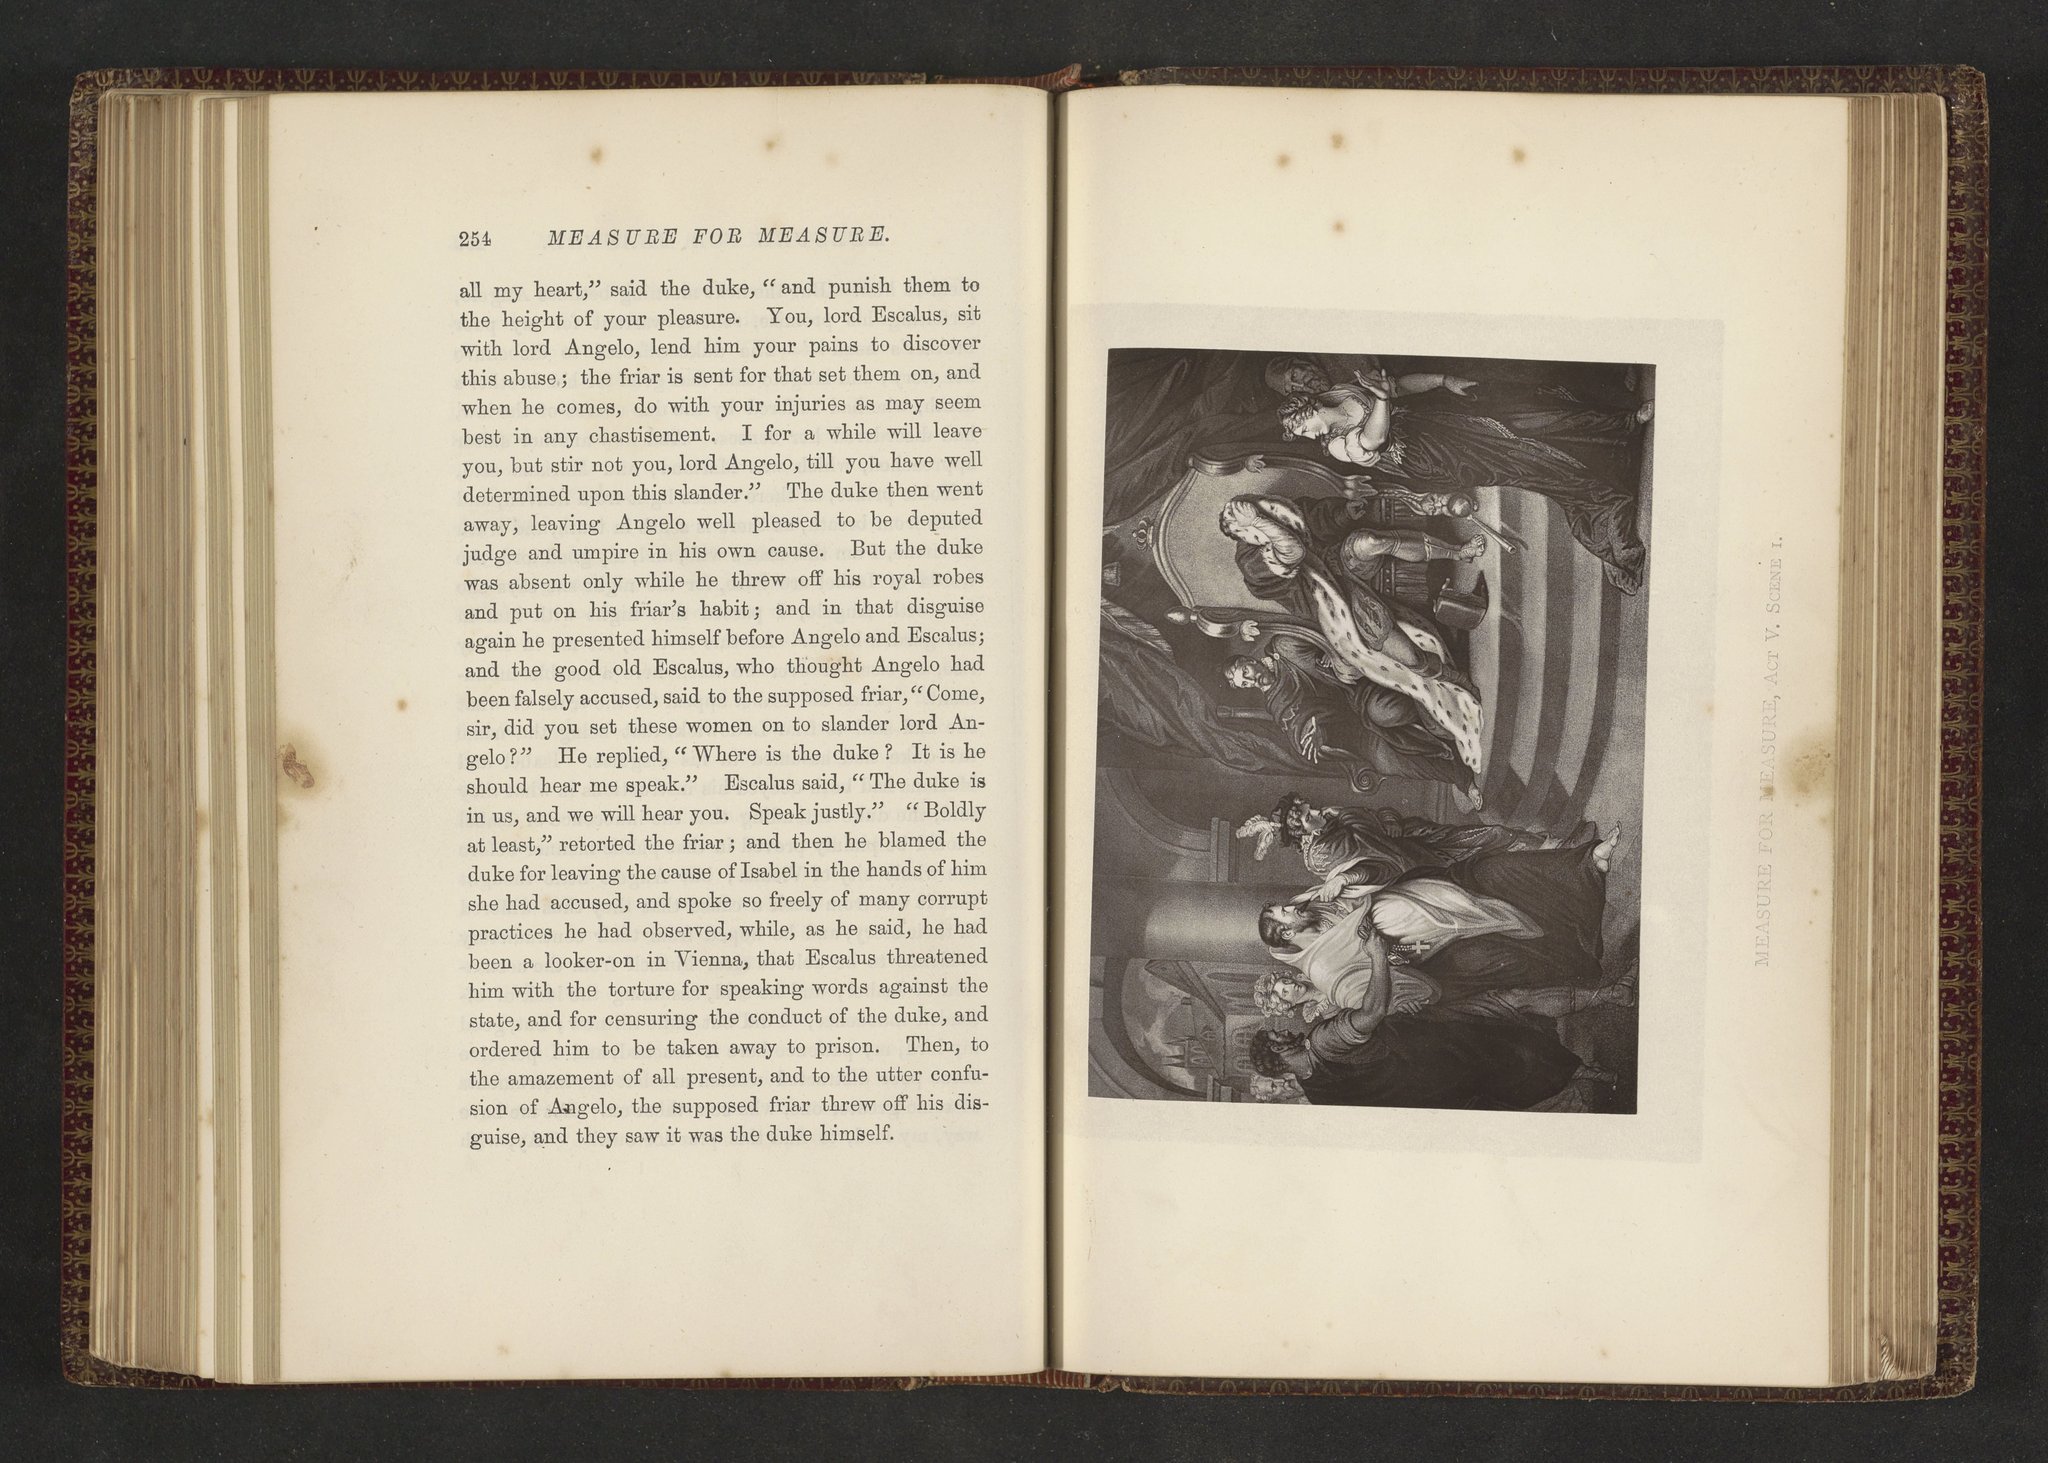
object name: photomechanical print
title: Fotoreproductie van een prent naar een schilderij van Thomas Kirk, voorstellend een scene uit Leer om leer door William Shakespeare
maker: Anonymous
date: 1873-1883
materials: paper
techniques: woodburytype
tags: theatre, theatrical performance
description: Te zien is de onthulling van de hertog van Wenen.